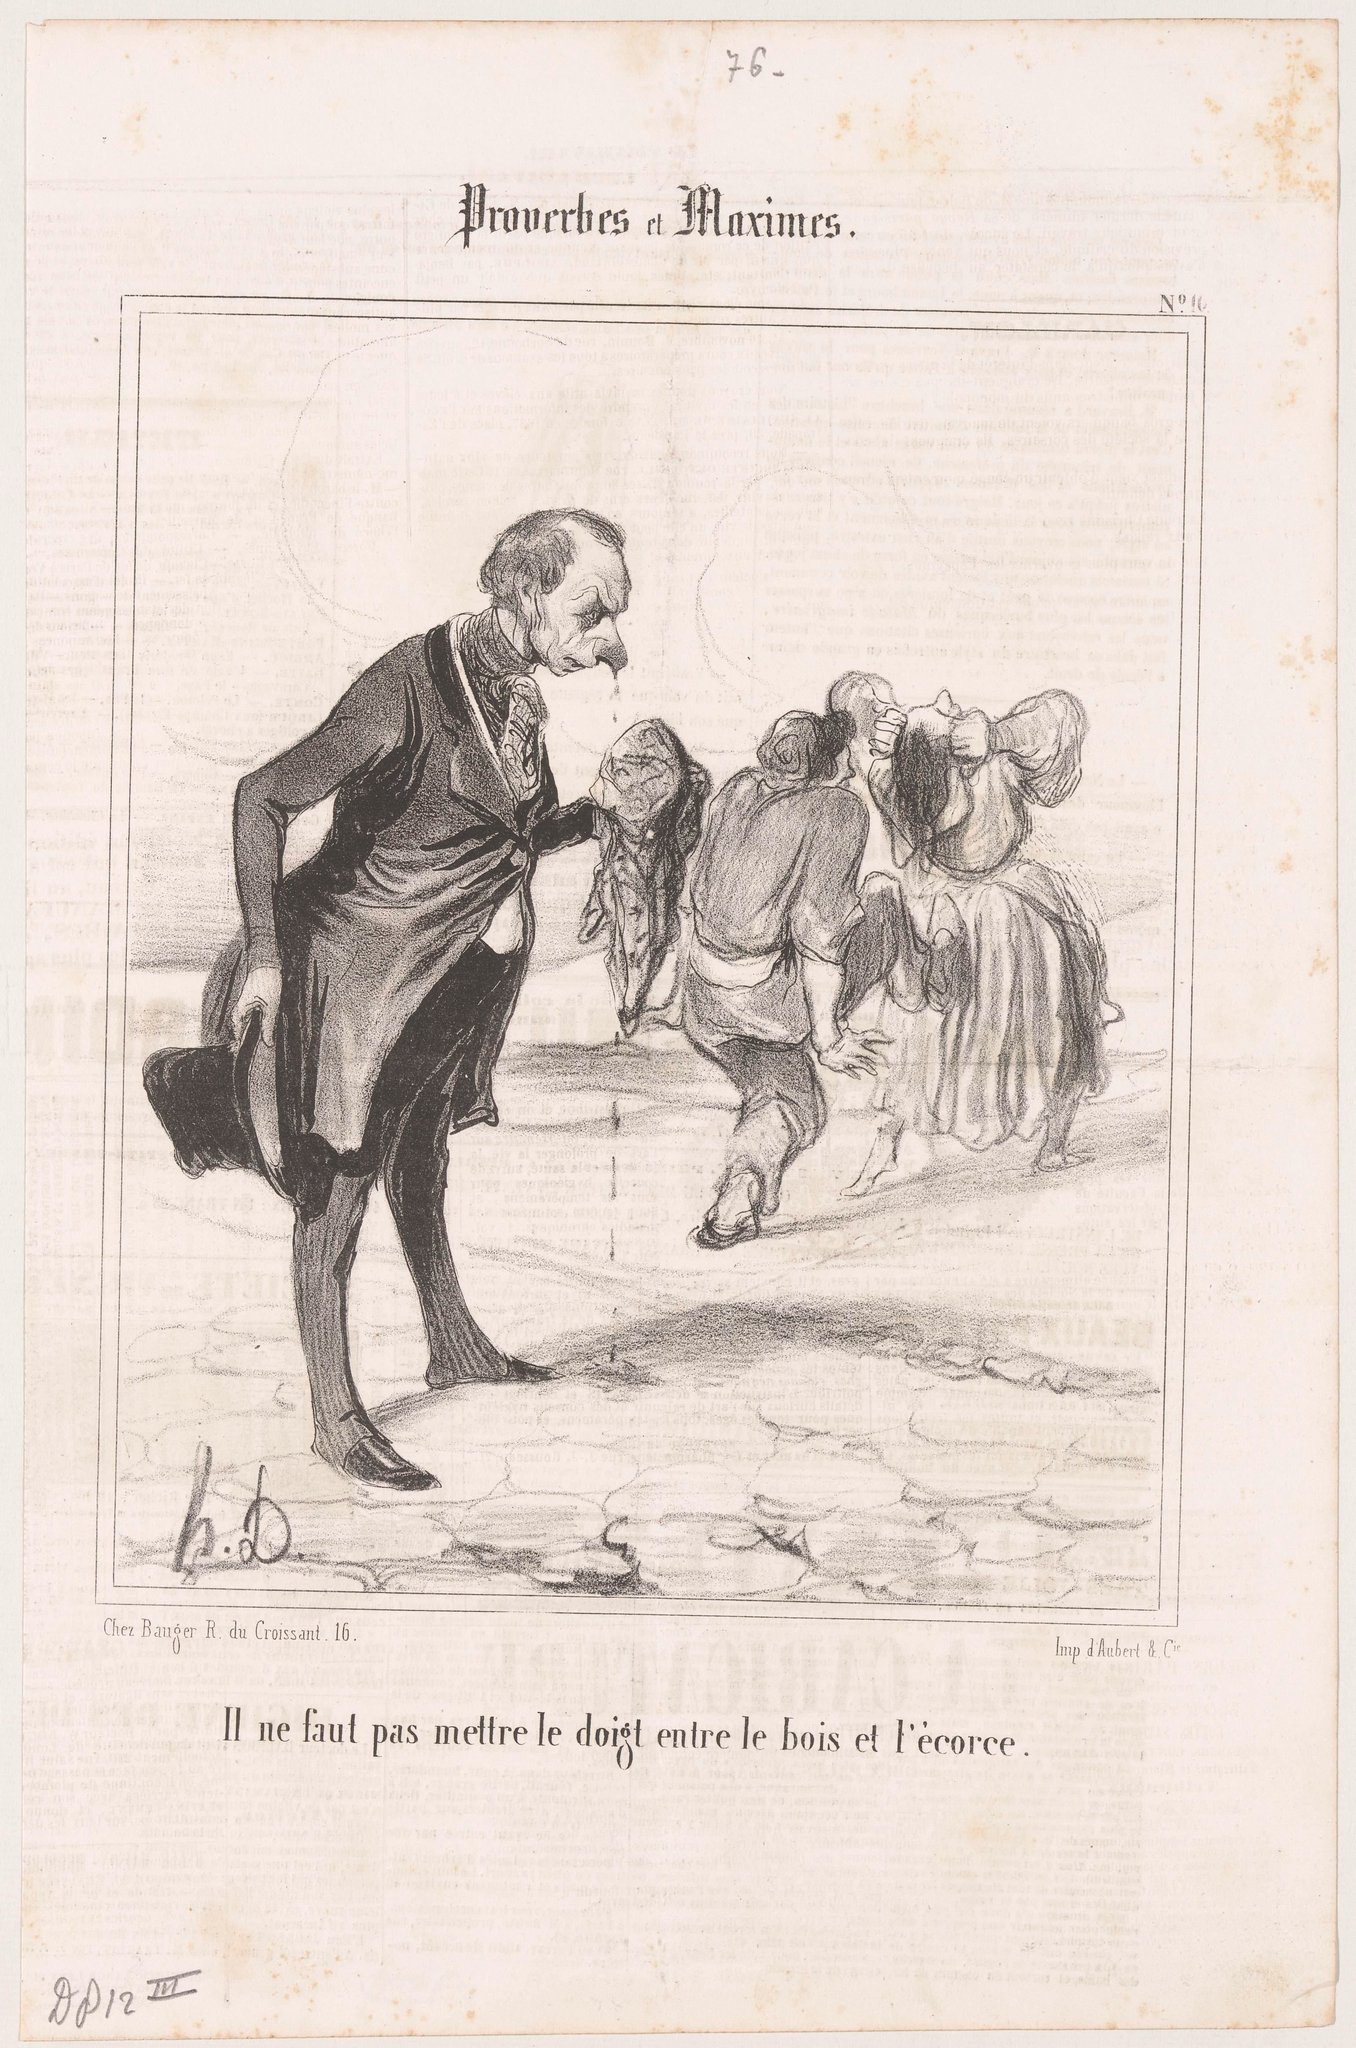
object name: cartoon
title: Il ne faut pas mettre le doigt entre le bois et l'écorce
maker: honoré daumier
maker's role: draughtsman, painter, print maker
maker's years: 1808-1879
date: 1840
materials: paper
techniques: letterpress printing, lithograph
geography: paris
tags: slap in the face, caricatures (human types)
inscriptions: collector's mark: Lugt 2228a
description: De man heeft een klap gekregen nadat hij zich tussen een ruziemakende man en vrouw heeft gemengd.